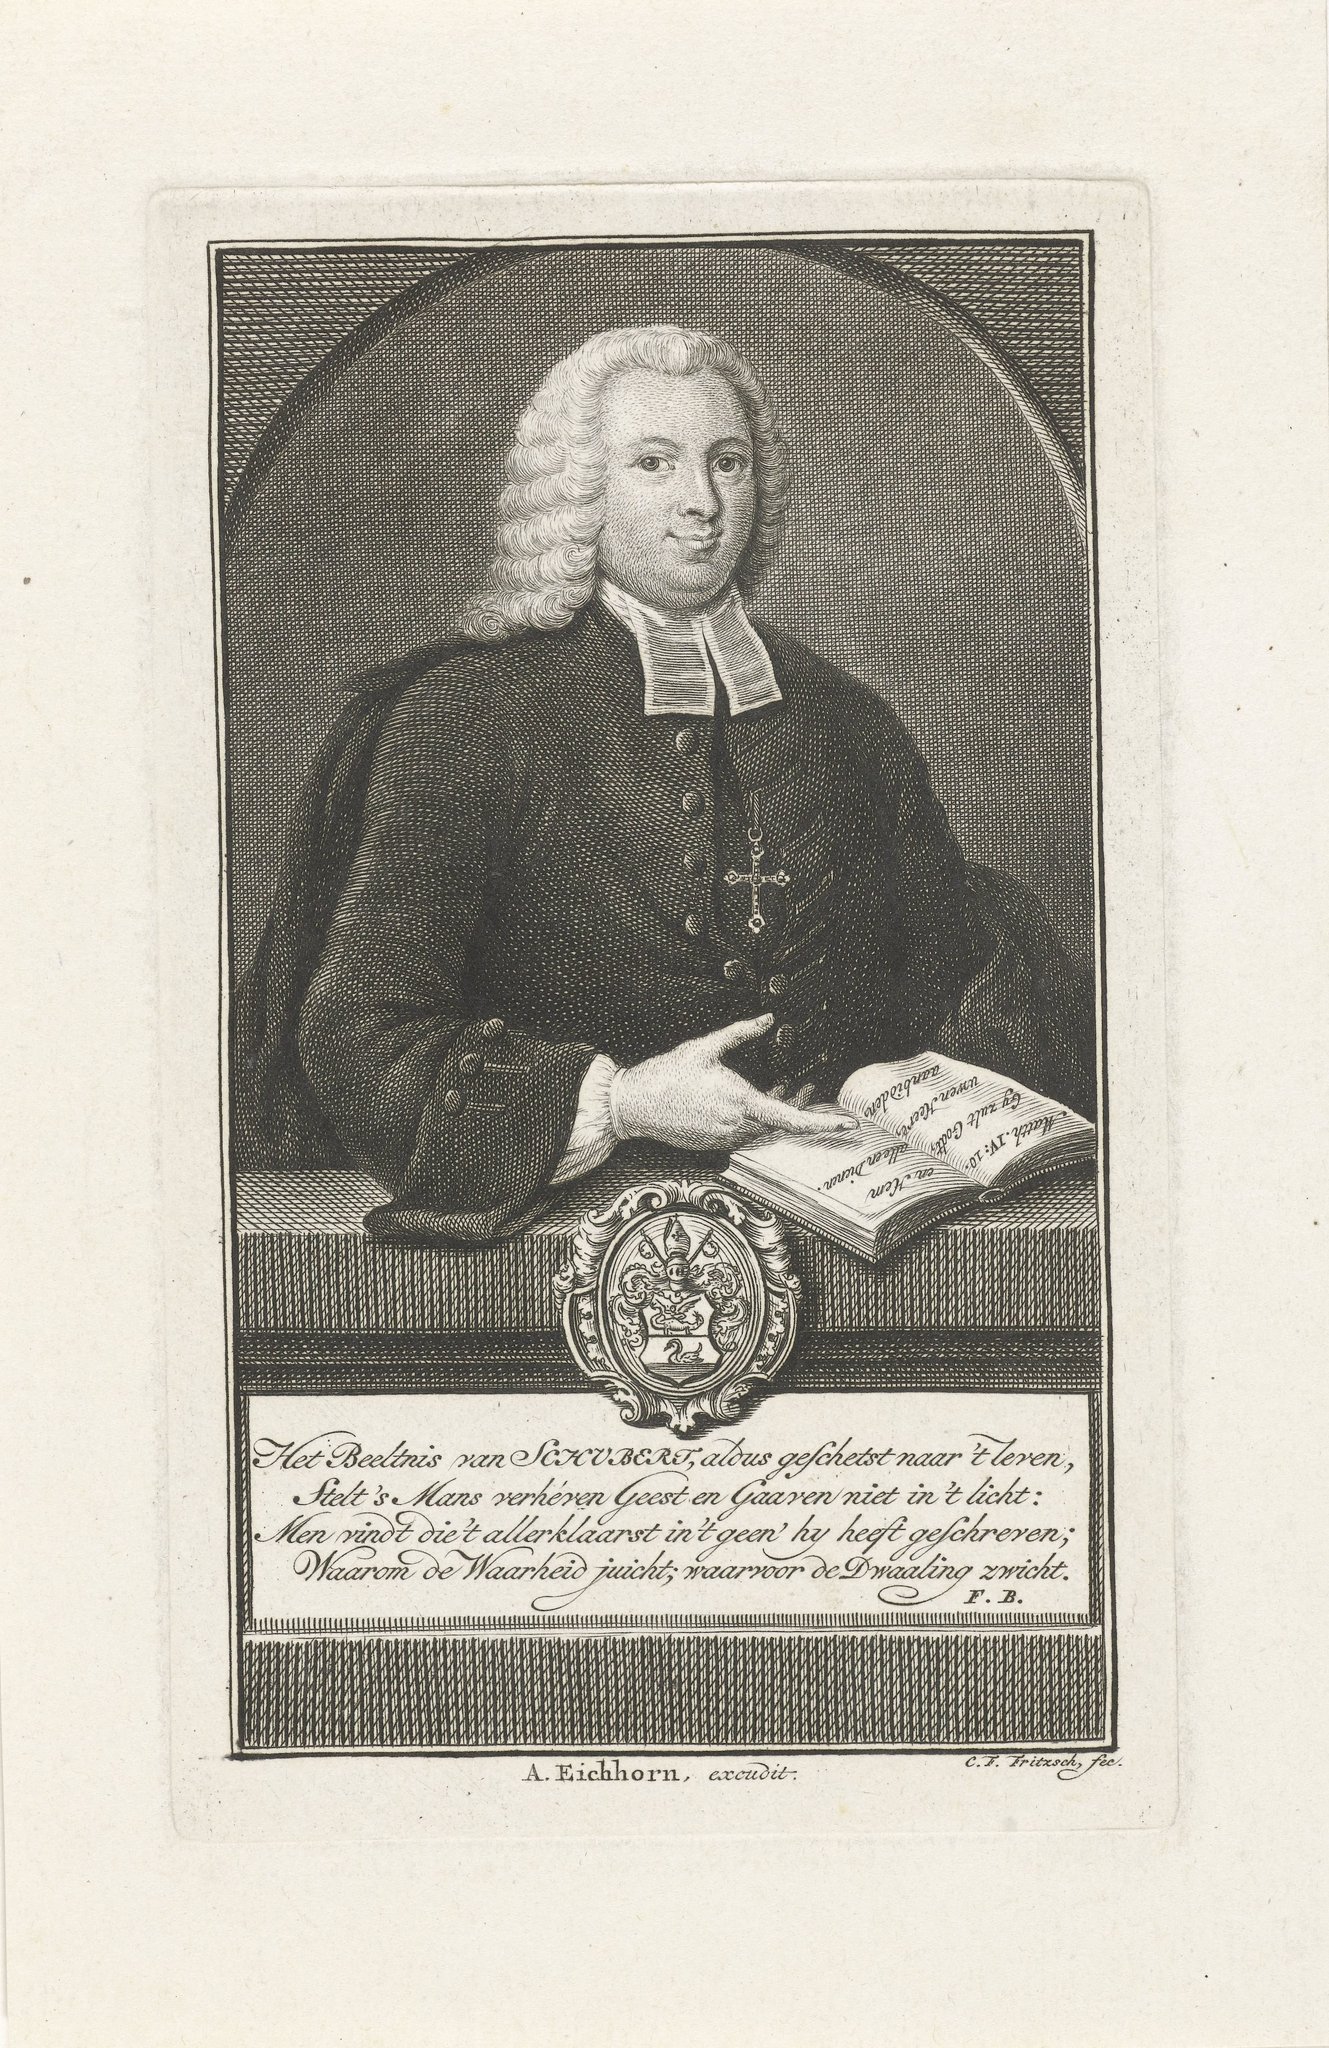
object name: print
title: Portret van dominee Schubert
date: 1772-1780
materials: paper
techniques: engraving, etching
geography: amsterdam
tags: schubert (dominee)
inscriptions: collector's mark: Lugt 2228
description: Portret van dominee Schubert, ten halven lijve naar rechts, blootshoofds. Met zijn rechterhand wijst hij op een boek dat voor hem ligt opengeslagen op een bijbelvers uit Mat. 4:10. Onder het portret staan een wapen binnen een cartouche en een vierregelige tekst in het Nederlands.